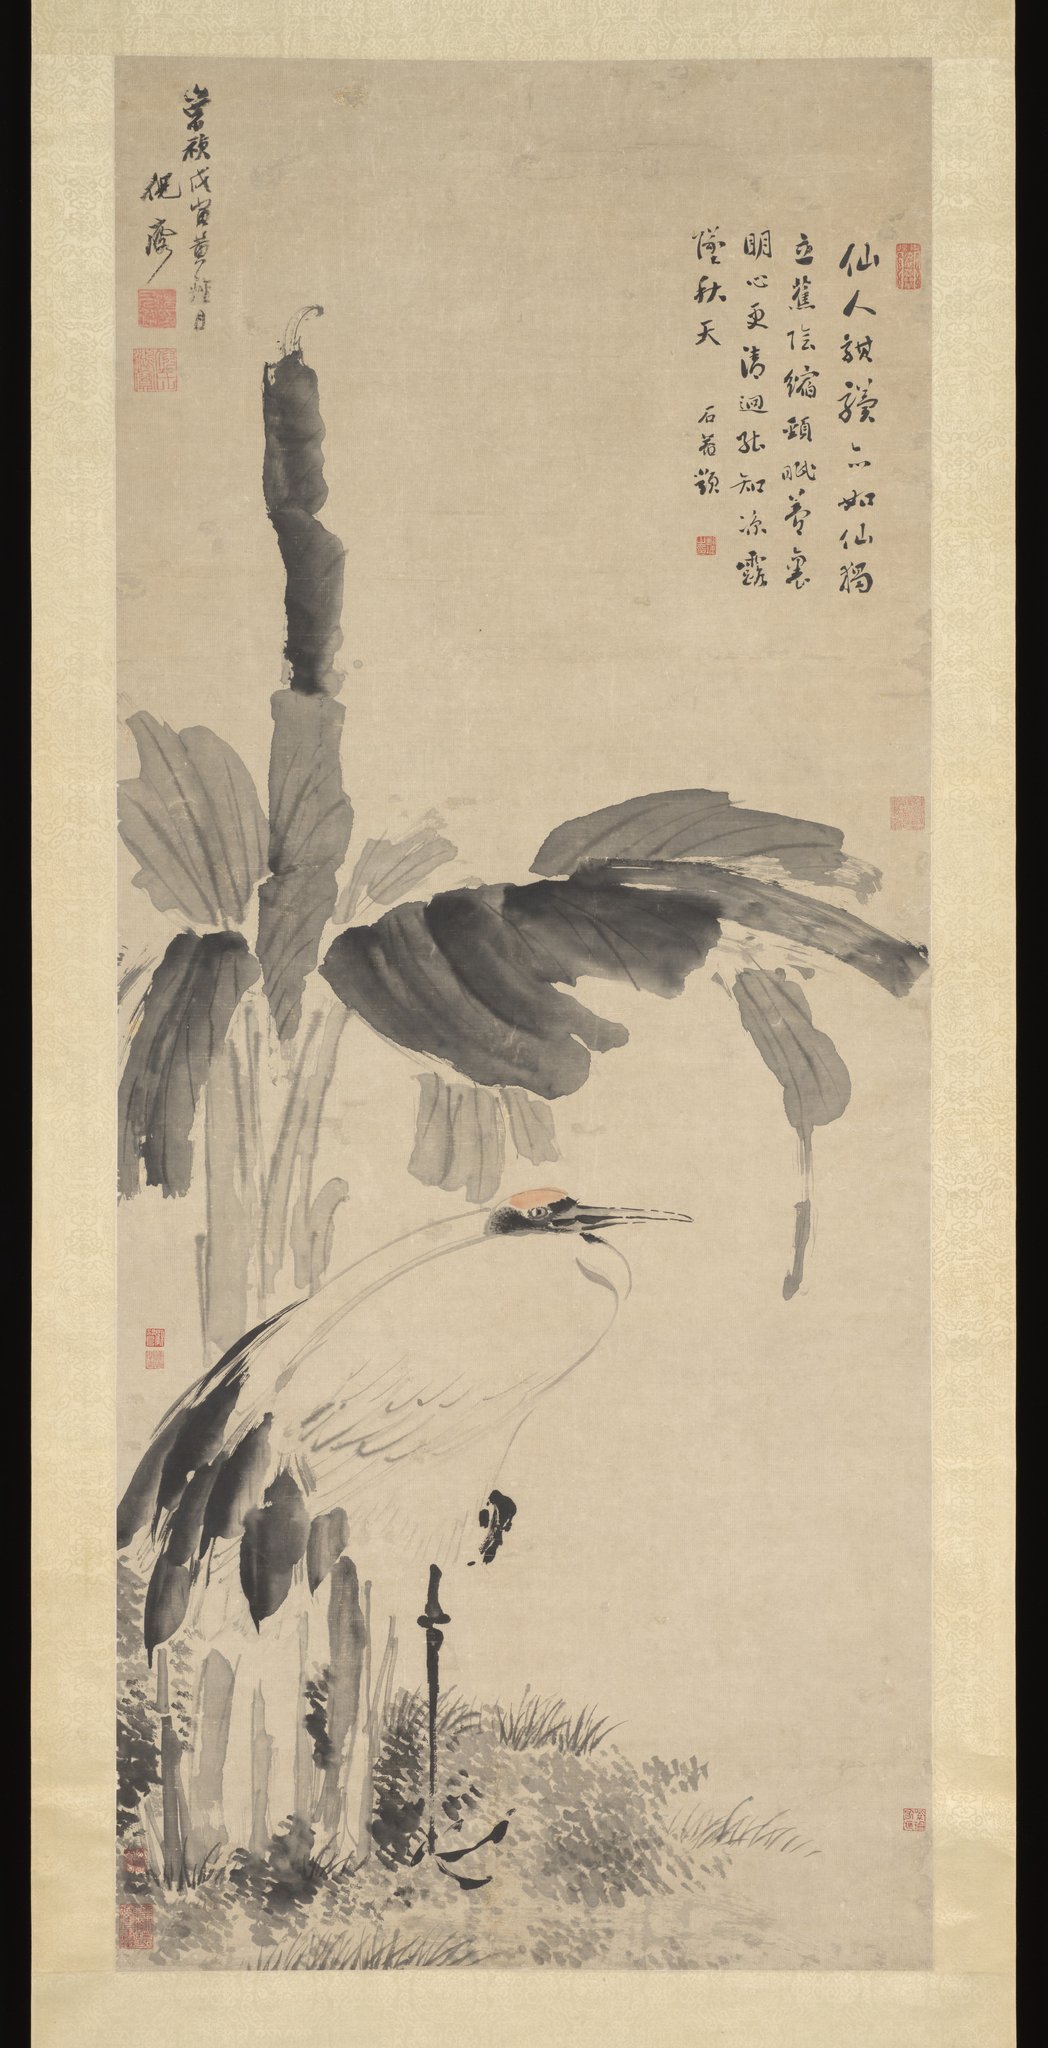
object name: hanging scroll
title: Crane Beneath a Banana Tree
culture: chinese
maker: unidentified artist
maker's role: artist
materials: ink, paper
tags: cranes